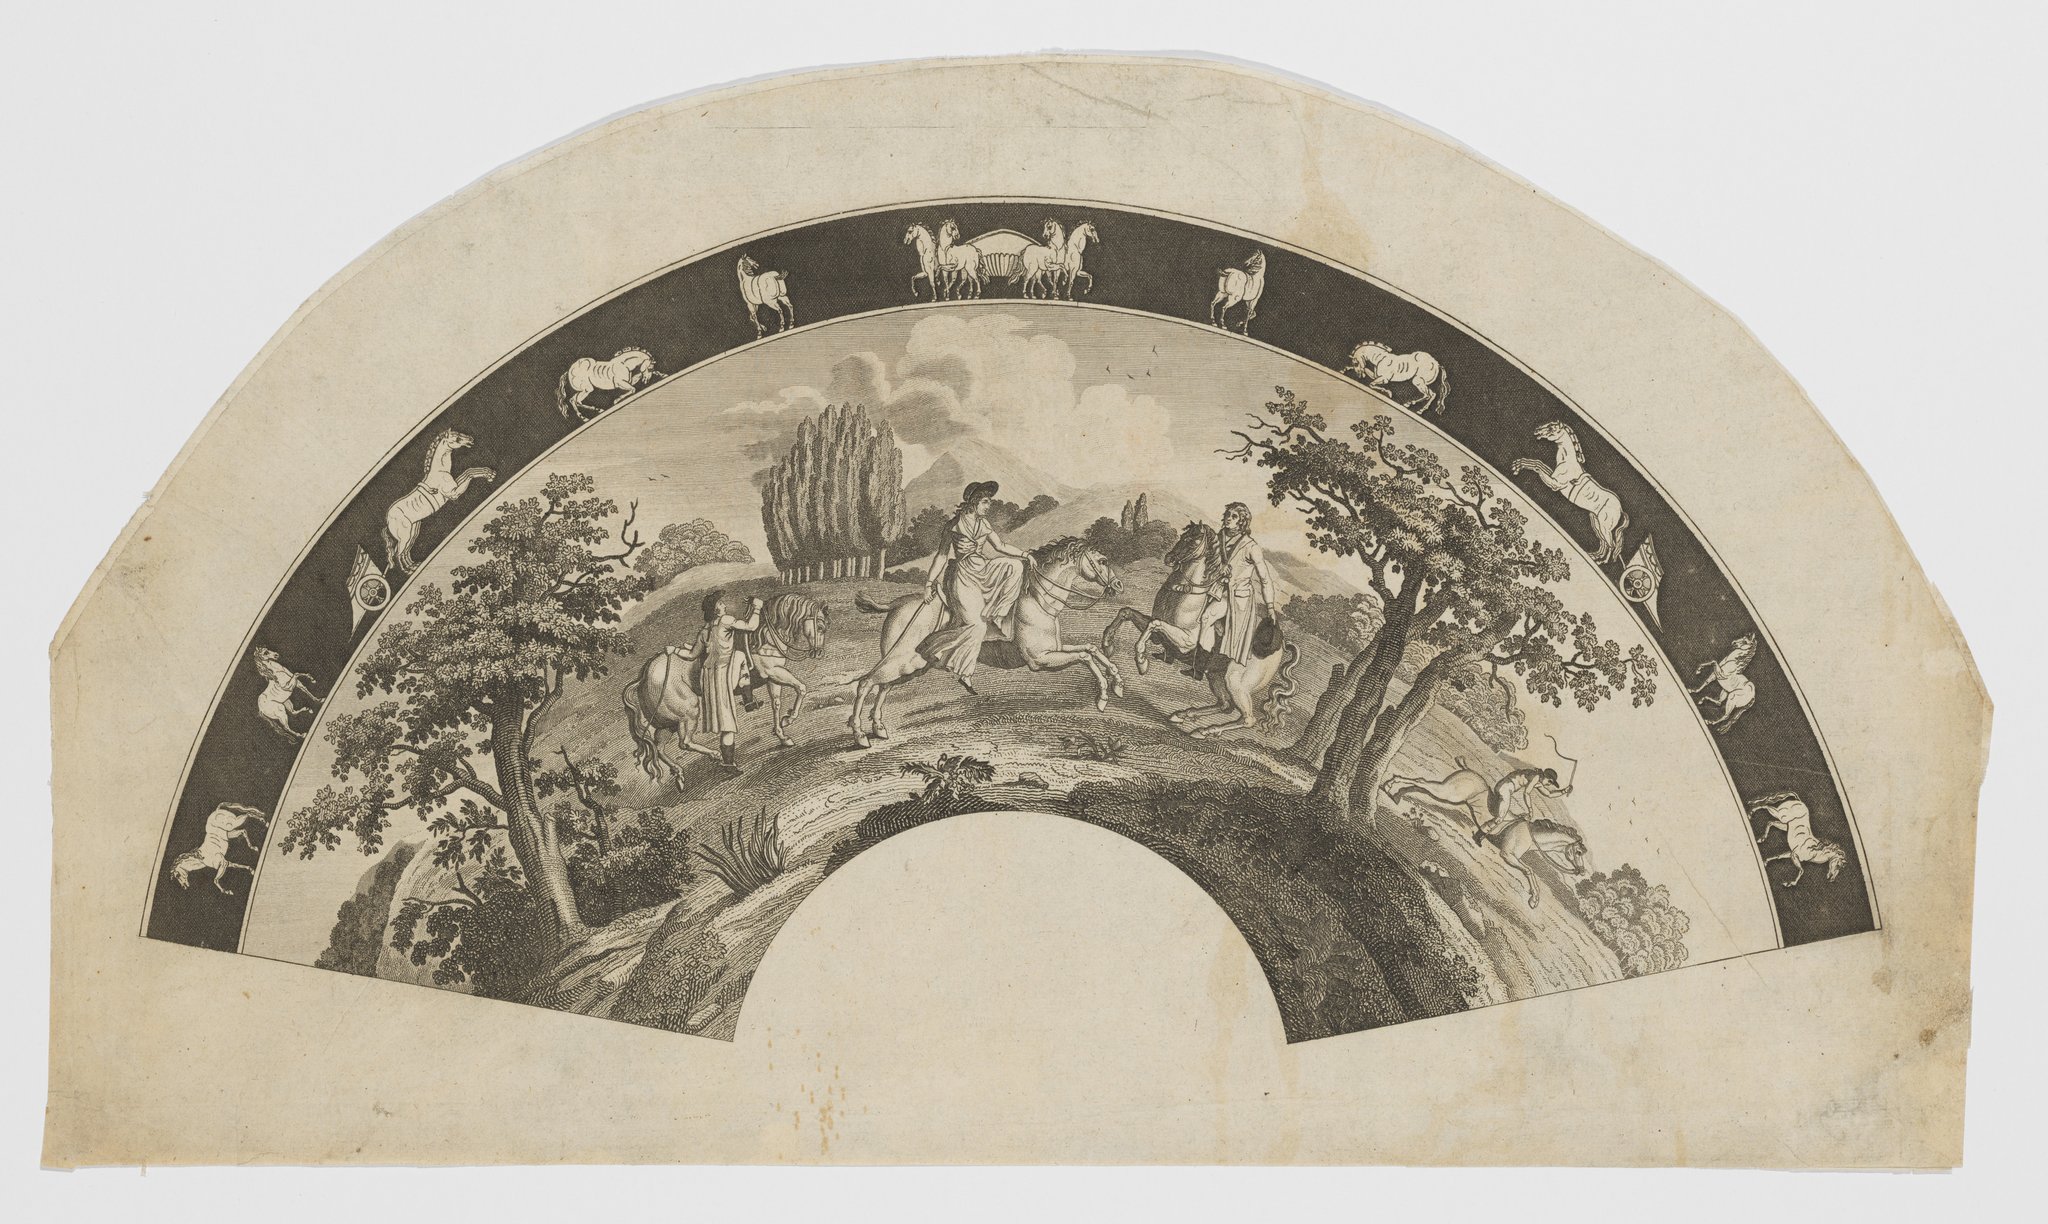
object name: print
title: Fan leaf depicting a hunt scene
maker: anonymous, british, 19th century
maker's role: artist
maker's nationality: british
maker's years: 1800-1900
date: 1801-1900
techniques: engraving, etching